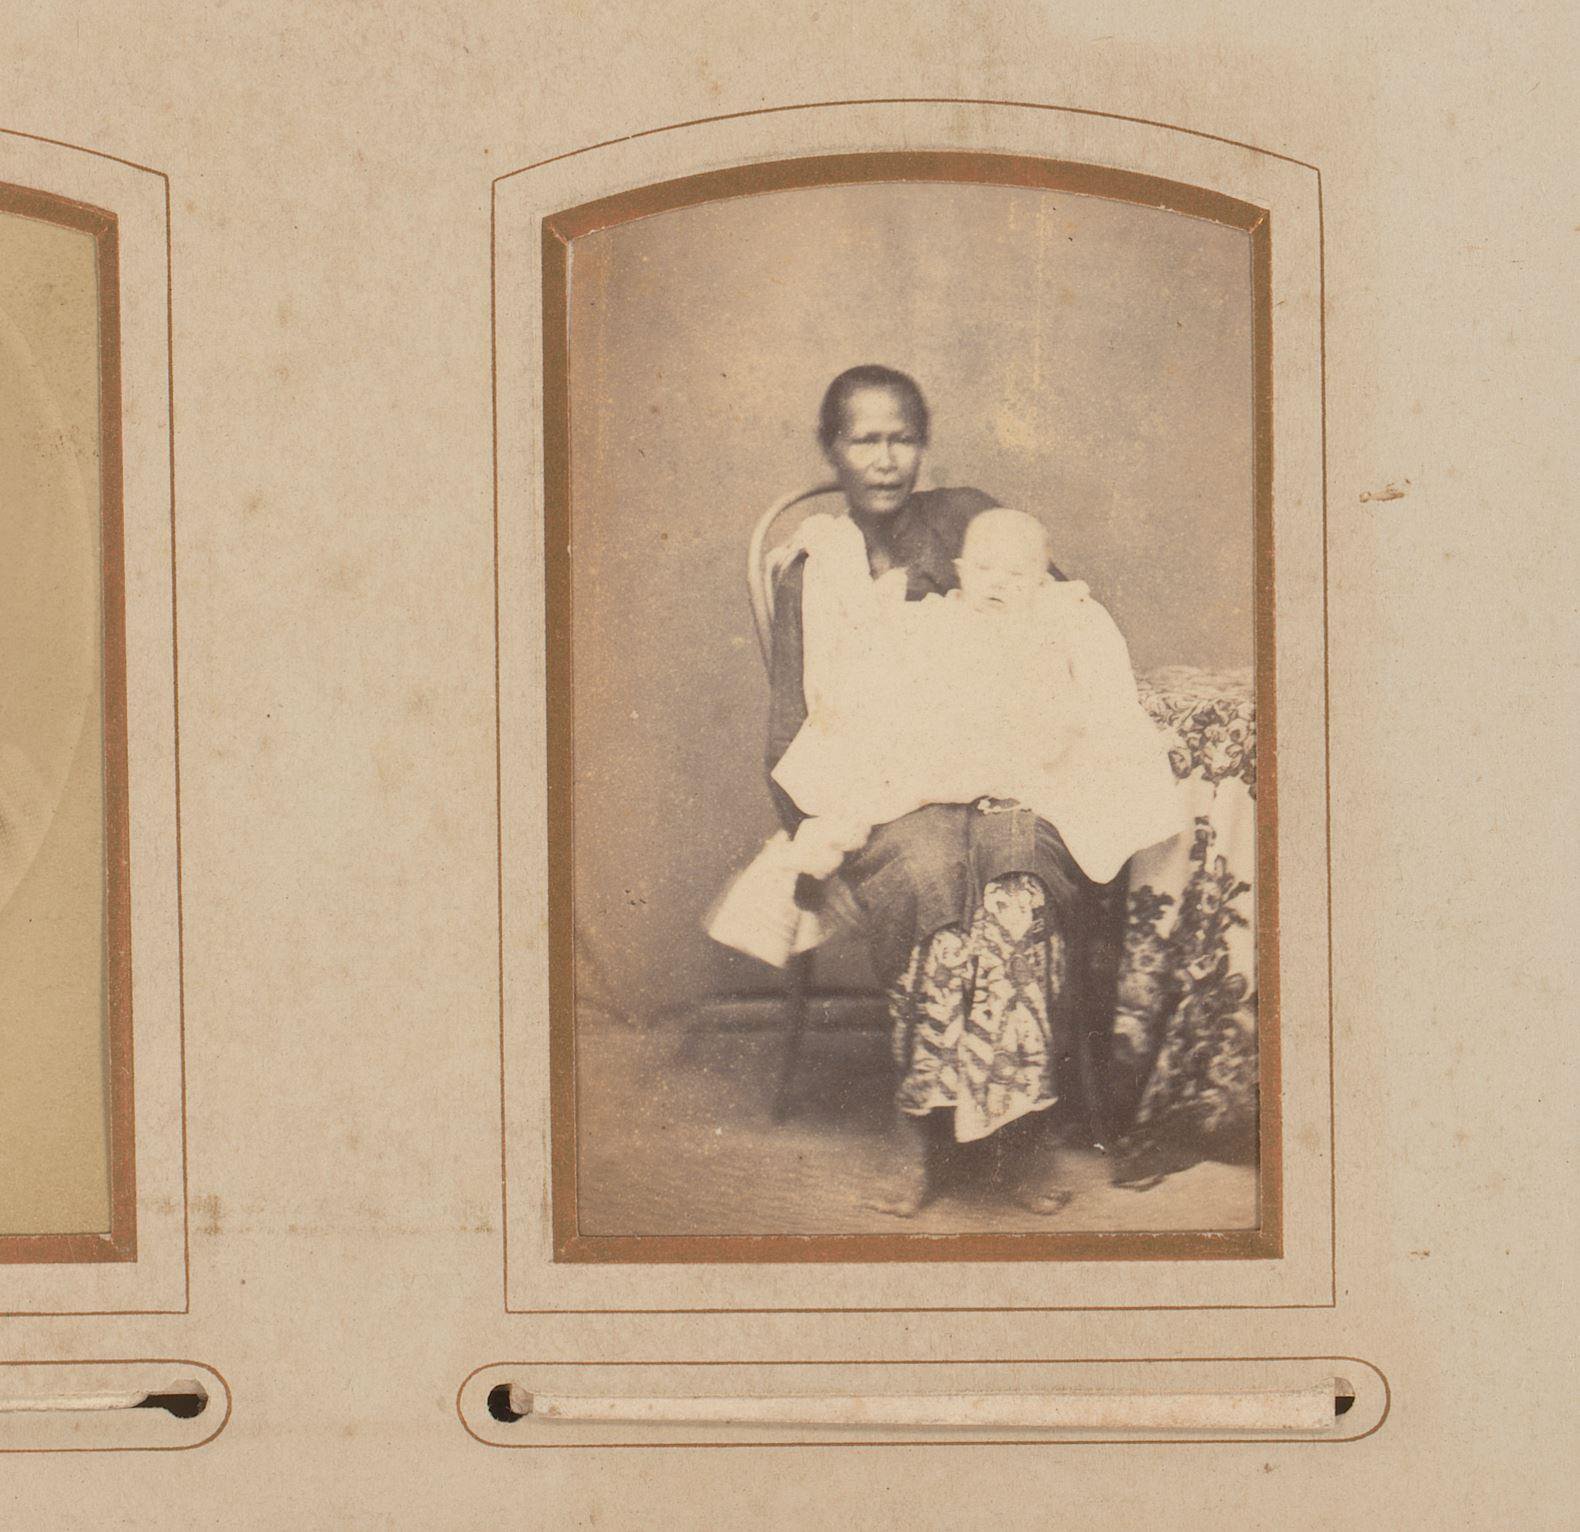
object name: album leaf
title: Portret van een zittende Indonesische vrouw met een Europese baby op schoot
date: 1857-1908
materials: cardboard, photographic support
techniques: albumen print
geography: java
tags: sitting figure - aa - female human figure, historical persons - bb - woman, infant, baby ~ the ages of man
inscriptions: inscription: ‘WOODBURY & PAGE,/ PHOTOGRAPHERS/ JAVA.’